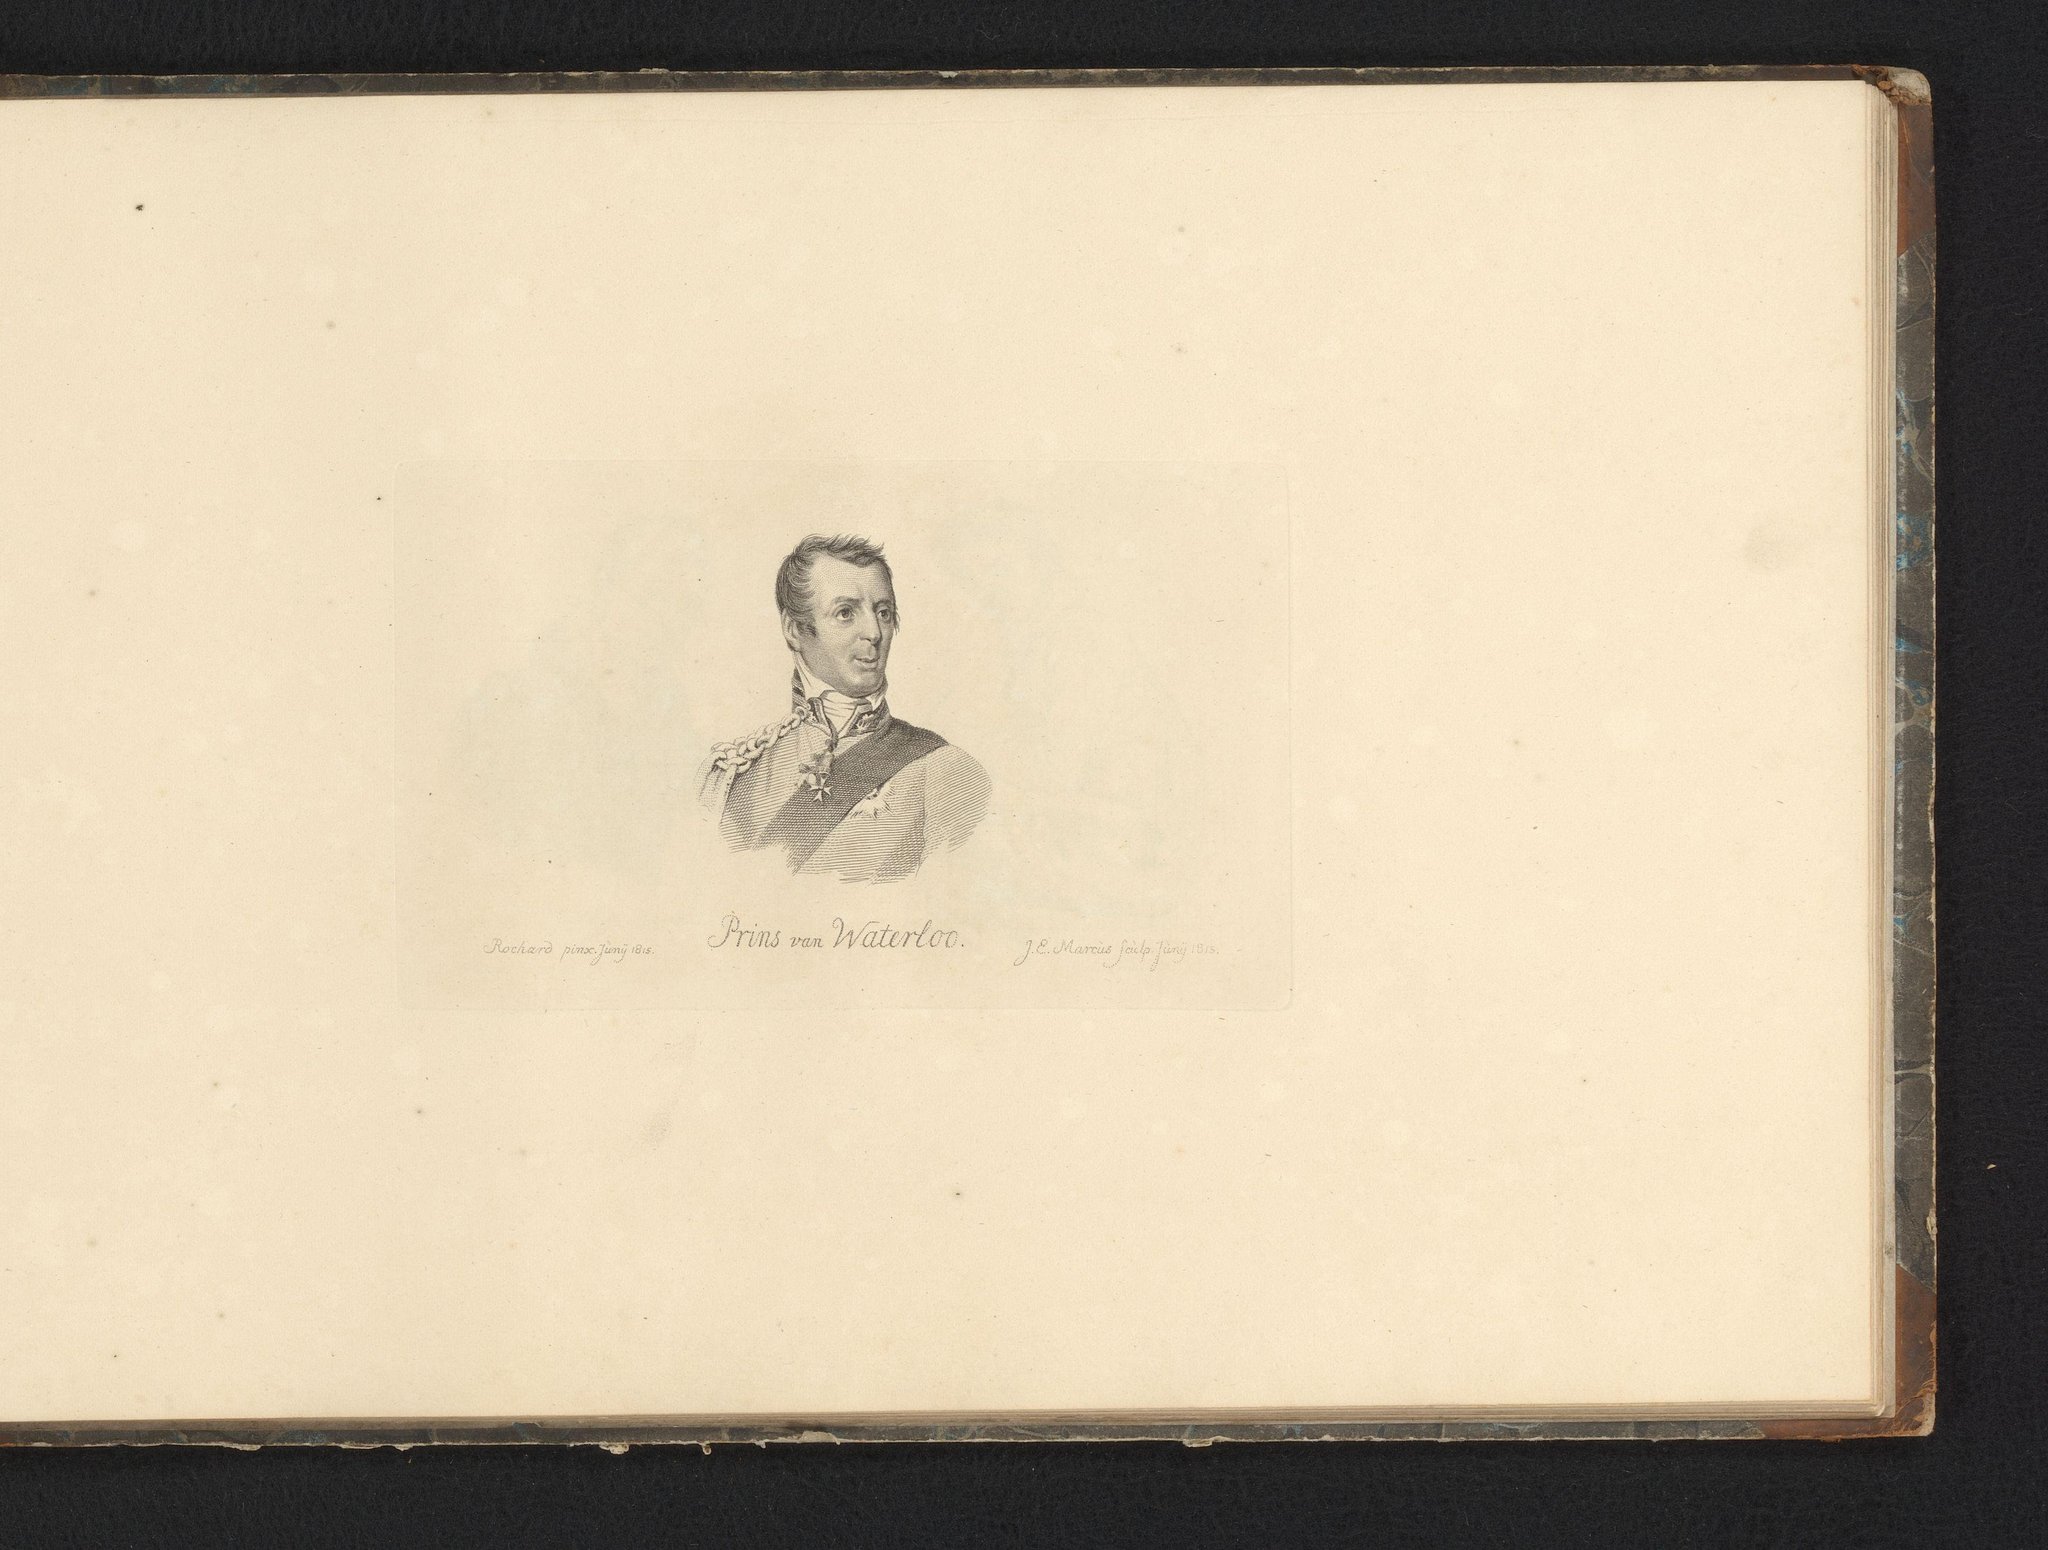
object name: print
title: Portret van Arthur Wellesley Wellington, prins van Waterloo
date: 1806-1815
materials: paper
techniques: etching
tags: walmer castle, arthur wellesley of wellington, historical persons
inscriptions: date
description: Deze prent maakt deel uit van een album.